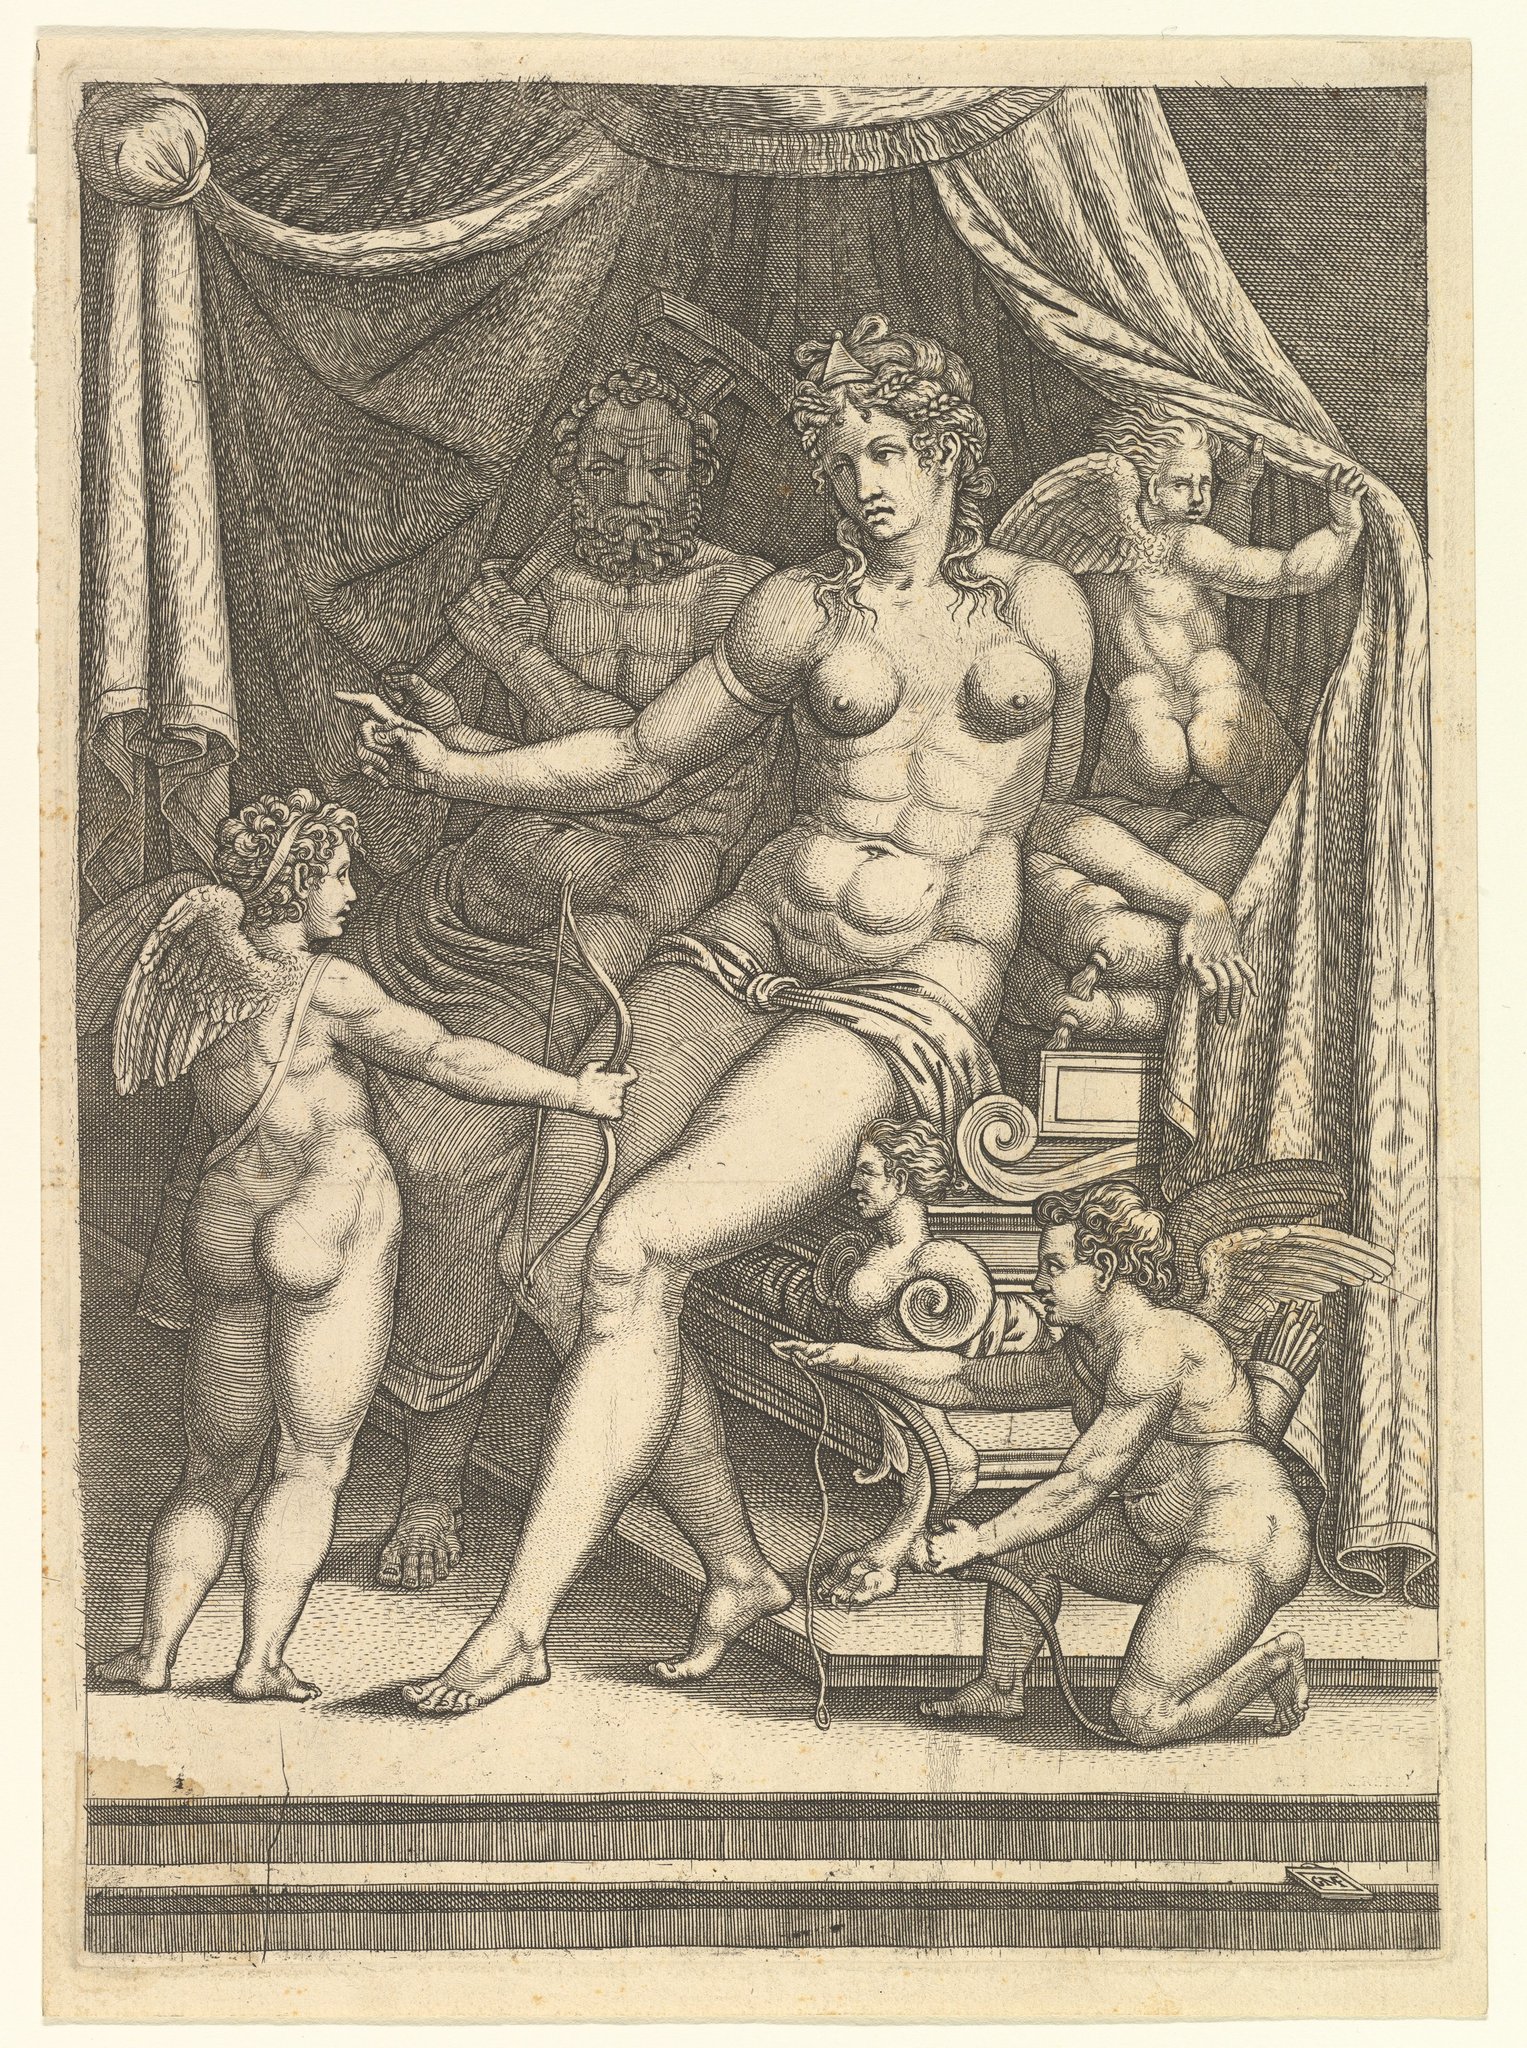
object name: print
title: Venus and Vulcan Seated on a Bed and Three Putti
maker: giorgio ghisi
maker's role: artist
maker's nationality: italian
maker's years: 1515-1582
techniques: engraving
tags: cupid,putti,venus,vulcan,beds